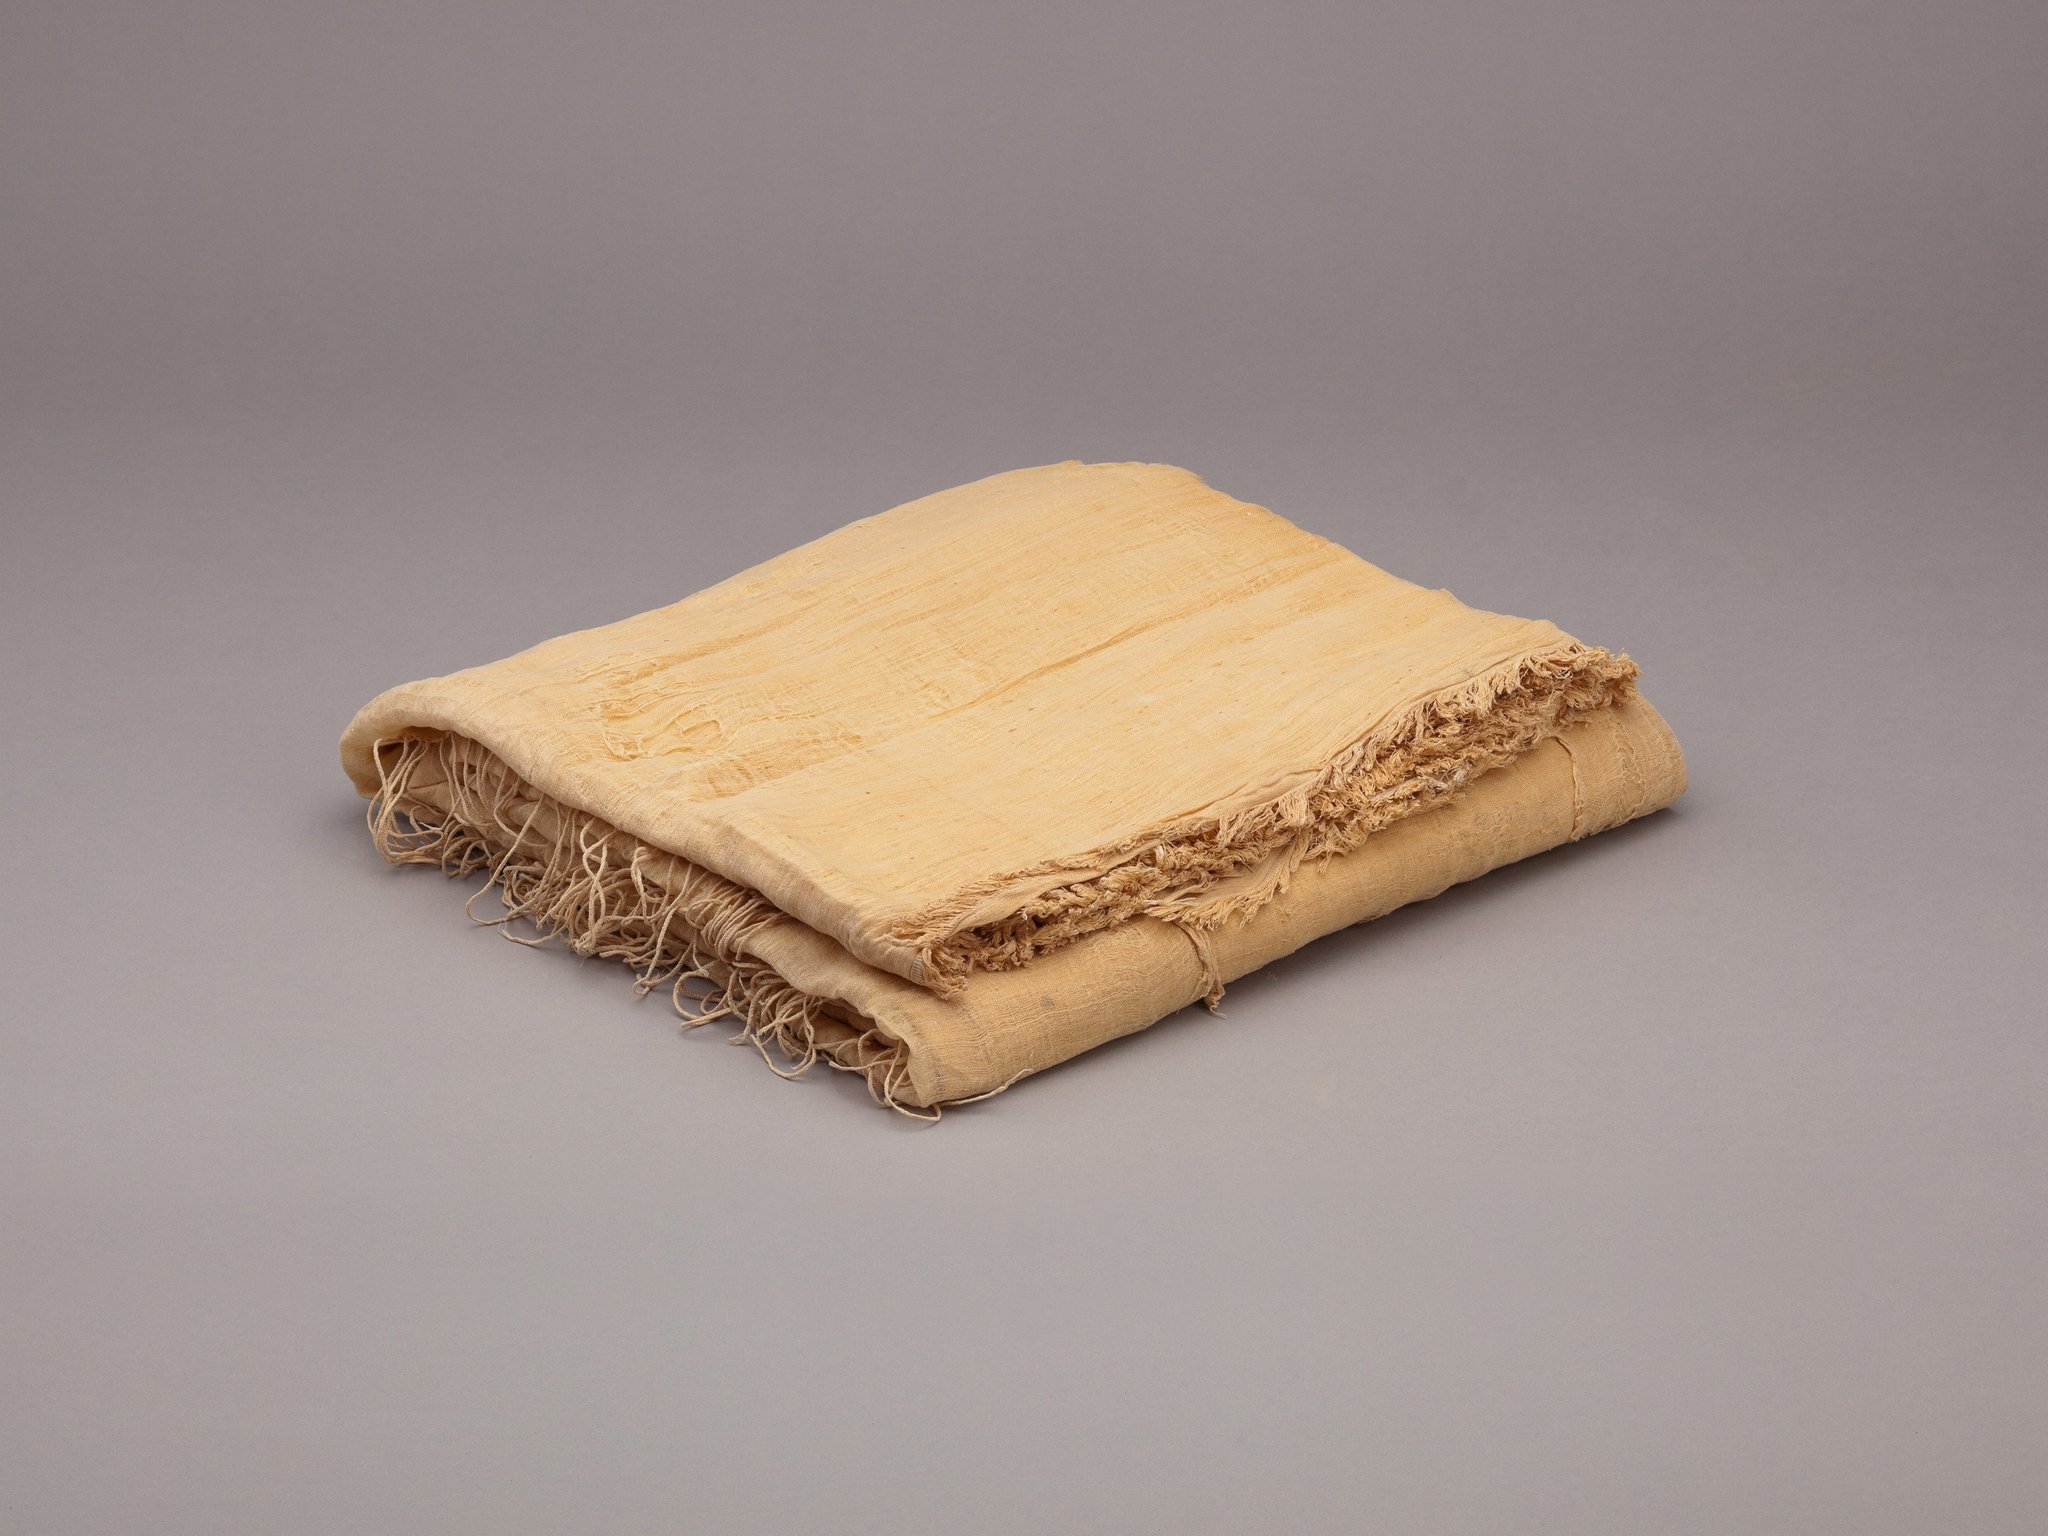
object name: linen mark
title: Sheet, linen mark, fine spin, fine weave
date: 1492-1473 BCE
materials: linen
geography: egypt